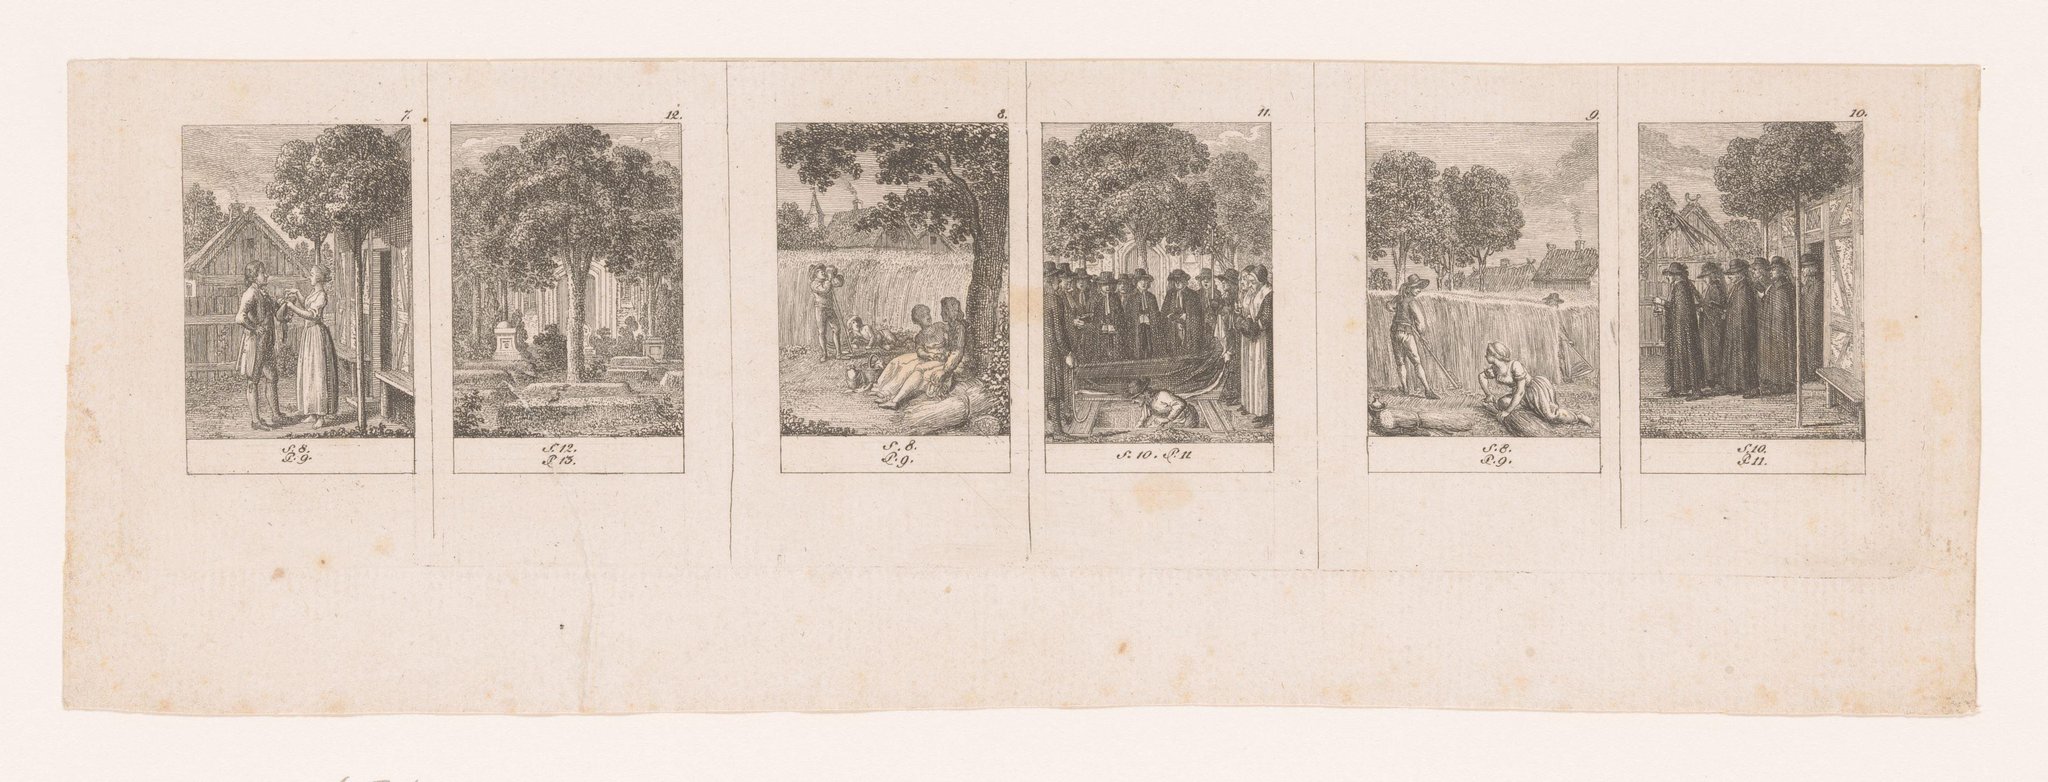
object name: print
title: Zes illustraties betreffende de begrafenis van een meisje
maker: Anonymous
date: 1750-1849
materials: paper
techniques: etching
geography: germany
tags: funerary ceremonial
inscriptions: collector's mark: Lugt 2228